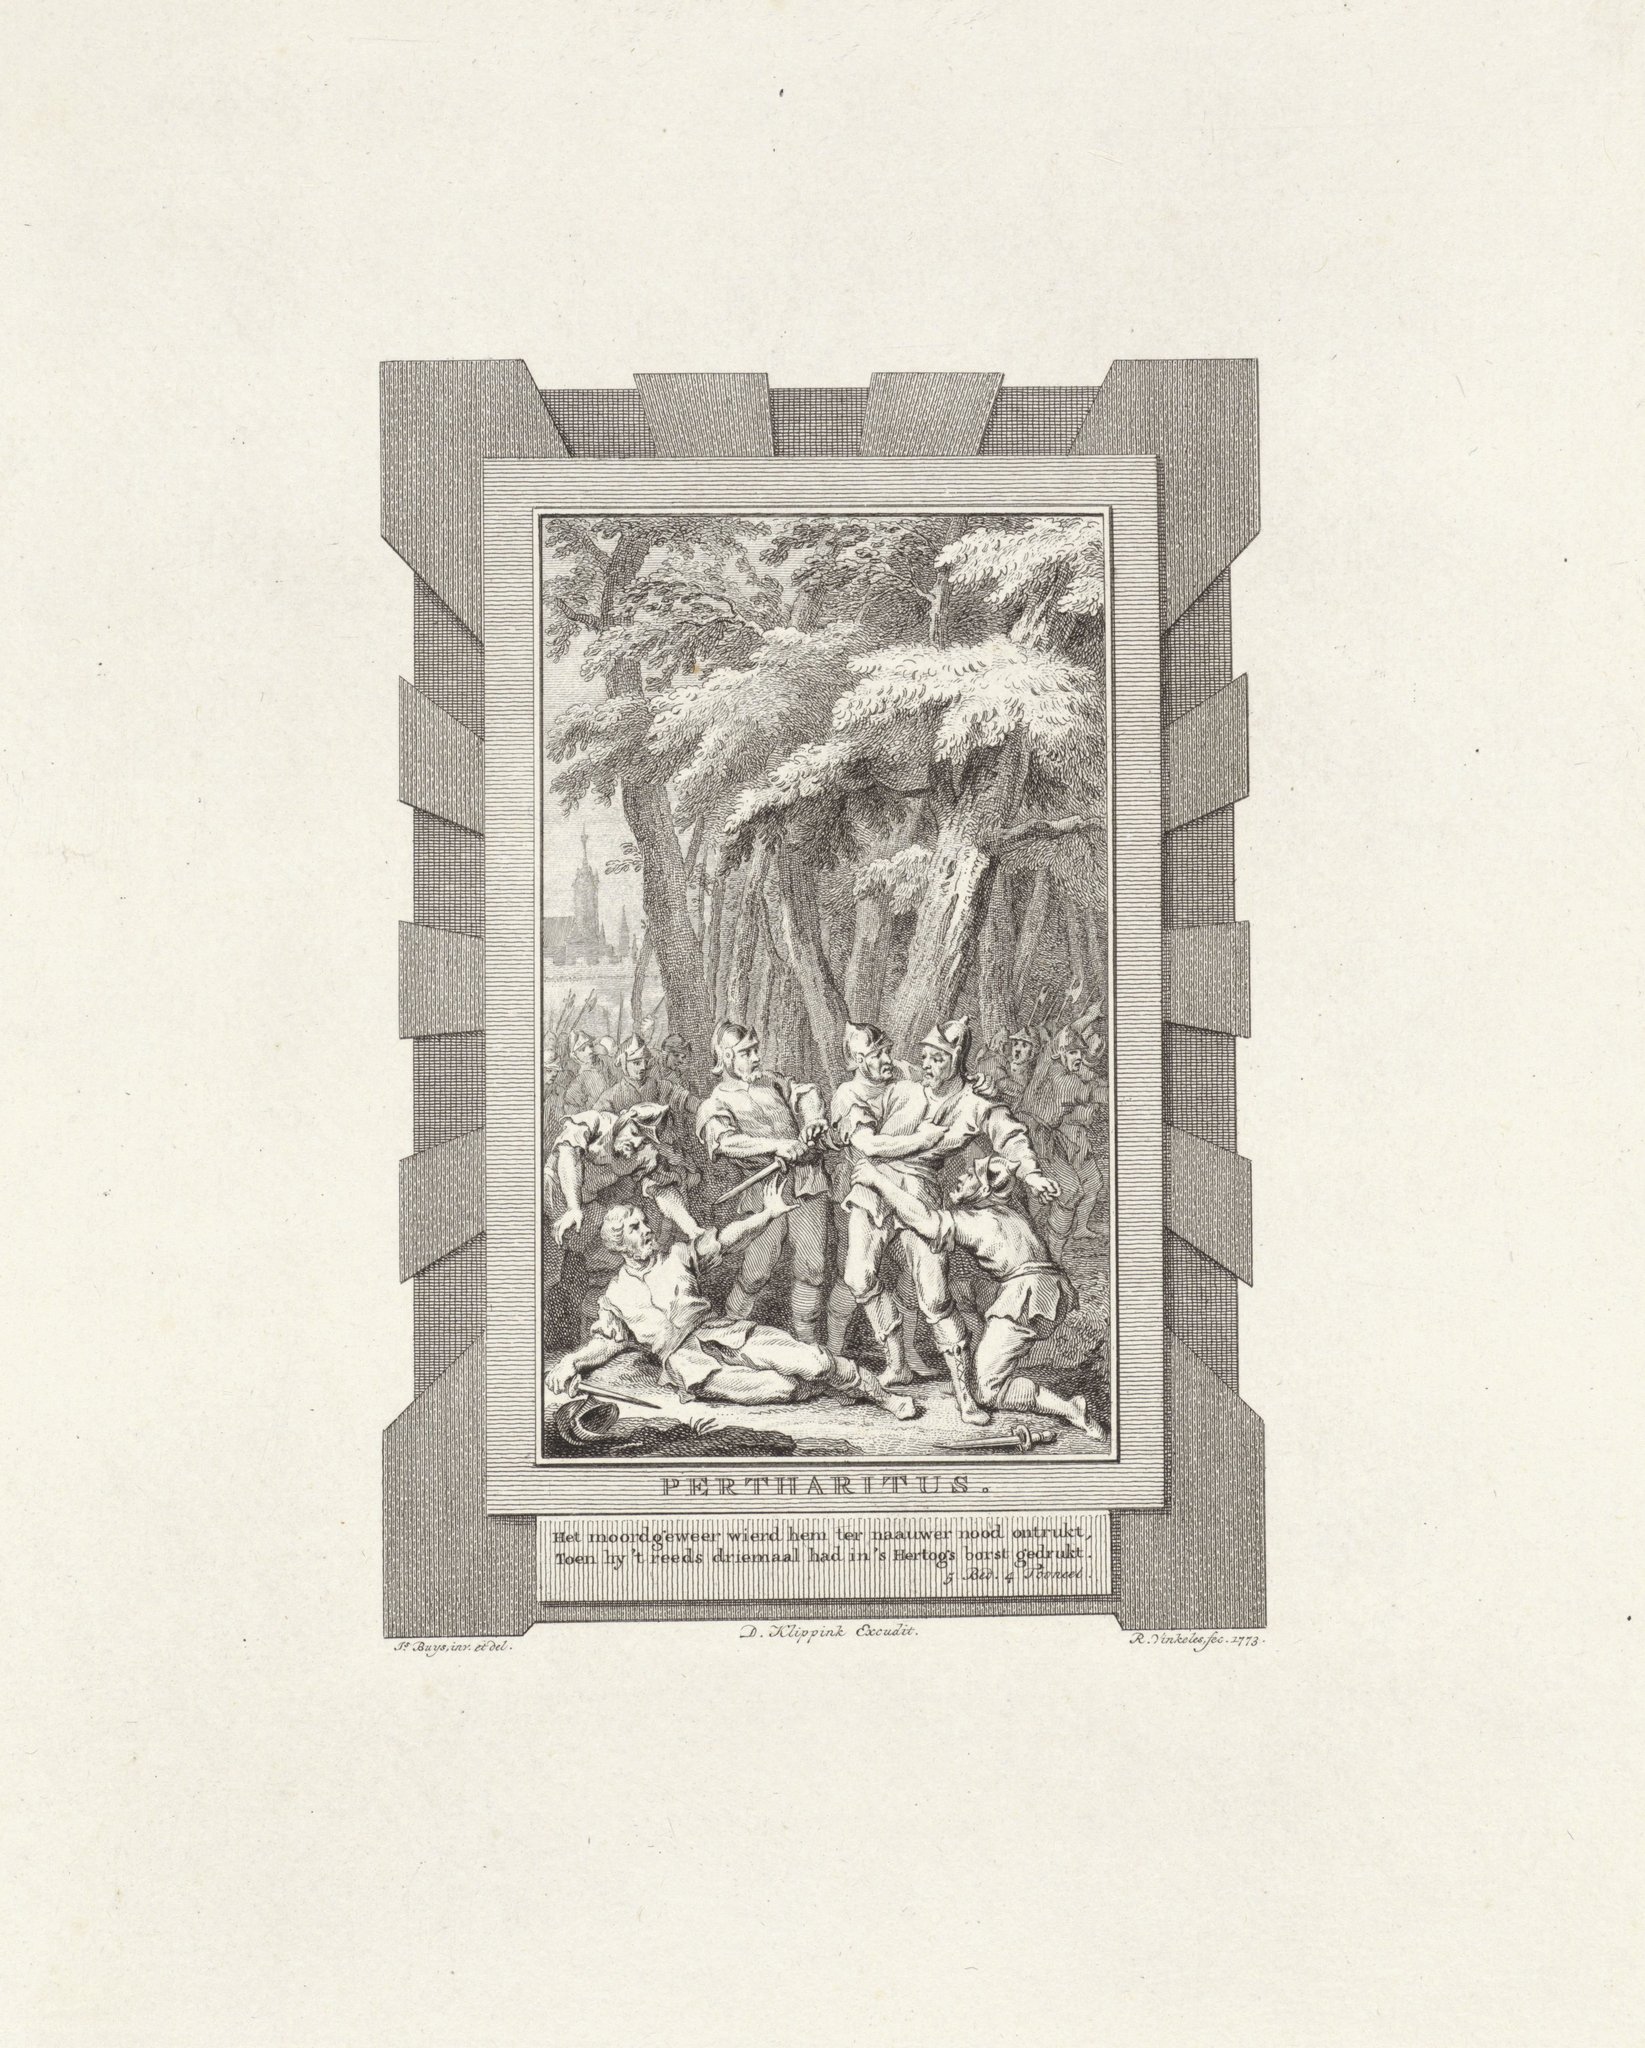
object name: print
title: Hertog Garibald wordt in het bos neergestoken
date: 1773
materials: paper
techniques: engraving, etching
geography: amsterdam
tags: forest, wood, fighting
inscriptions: collector's mark: Lugt 240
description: Prent naar illustratie in: Feitama, Sybrand. Pertharitus, Koning der Lombarden: treurspel. Amsterdam: Izaak Duin, 1756.